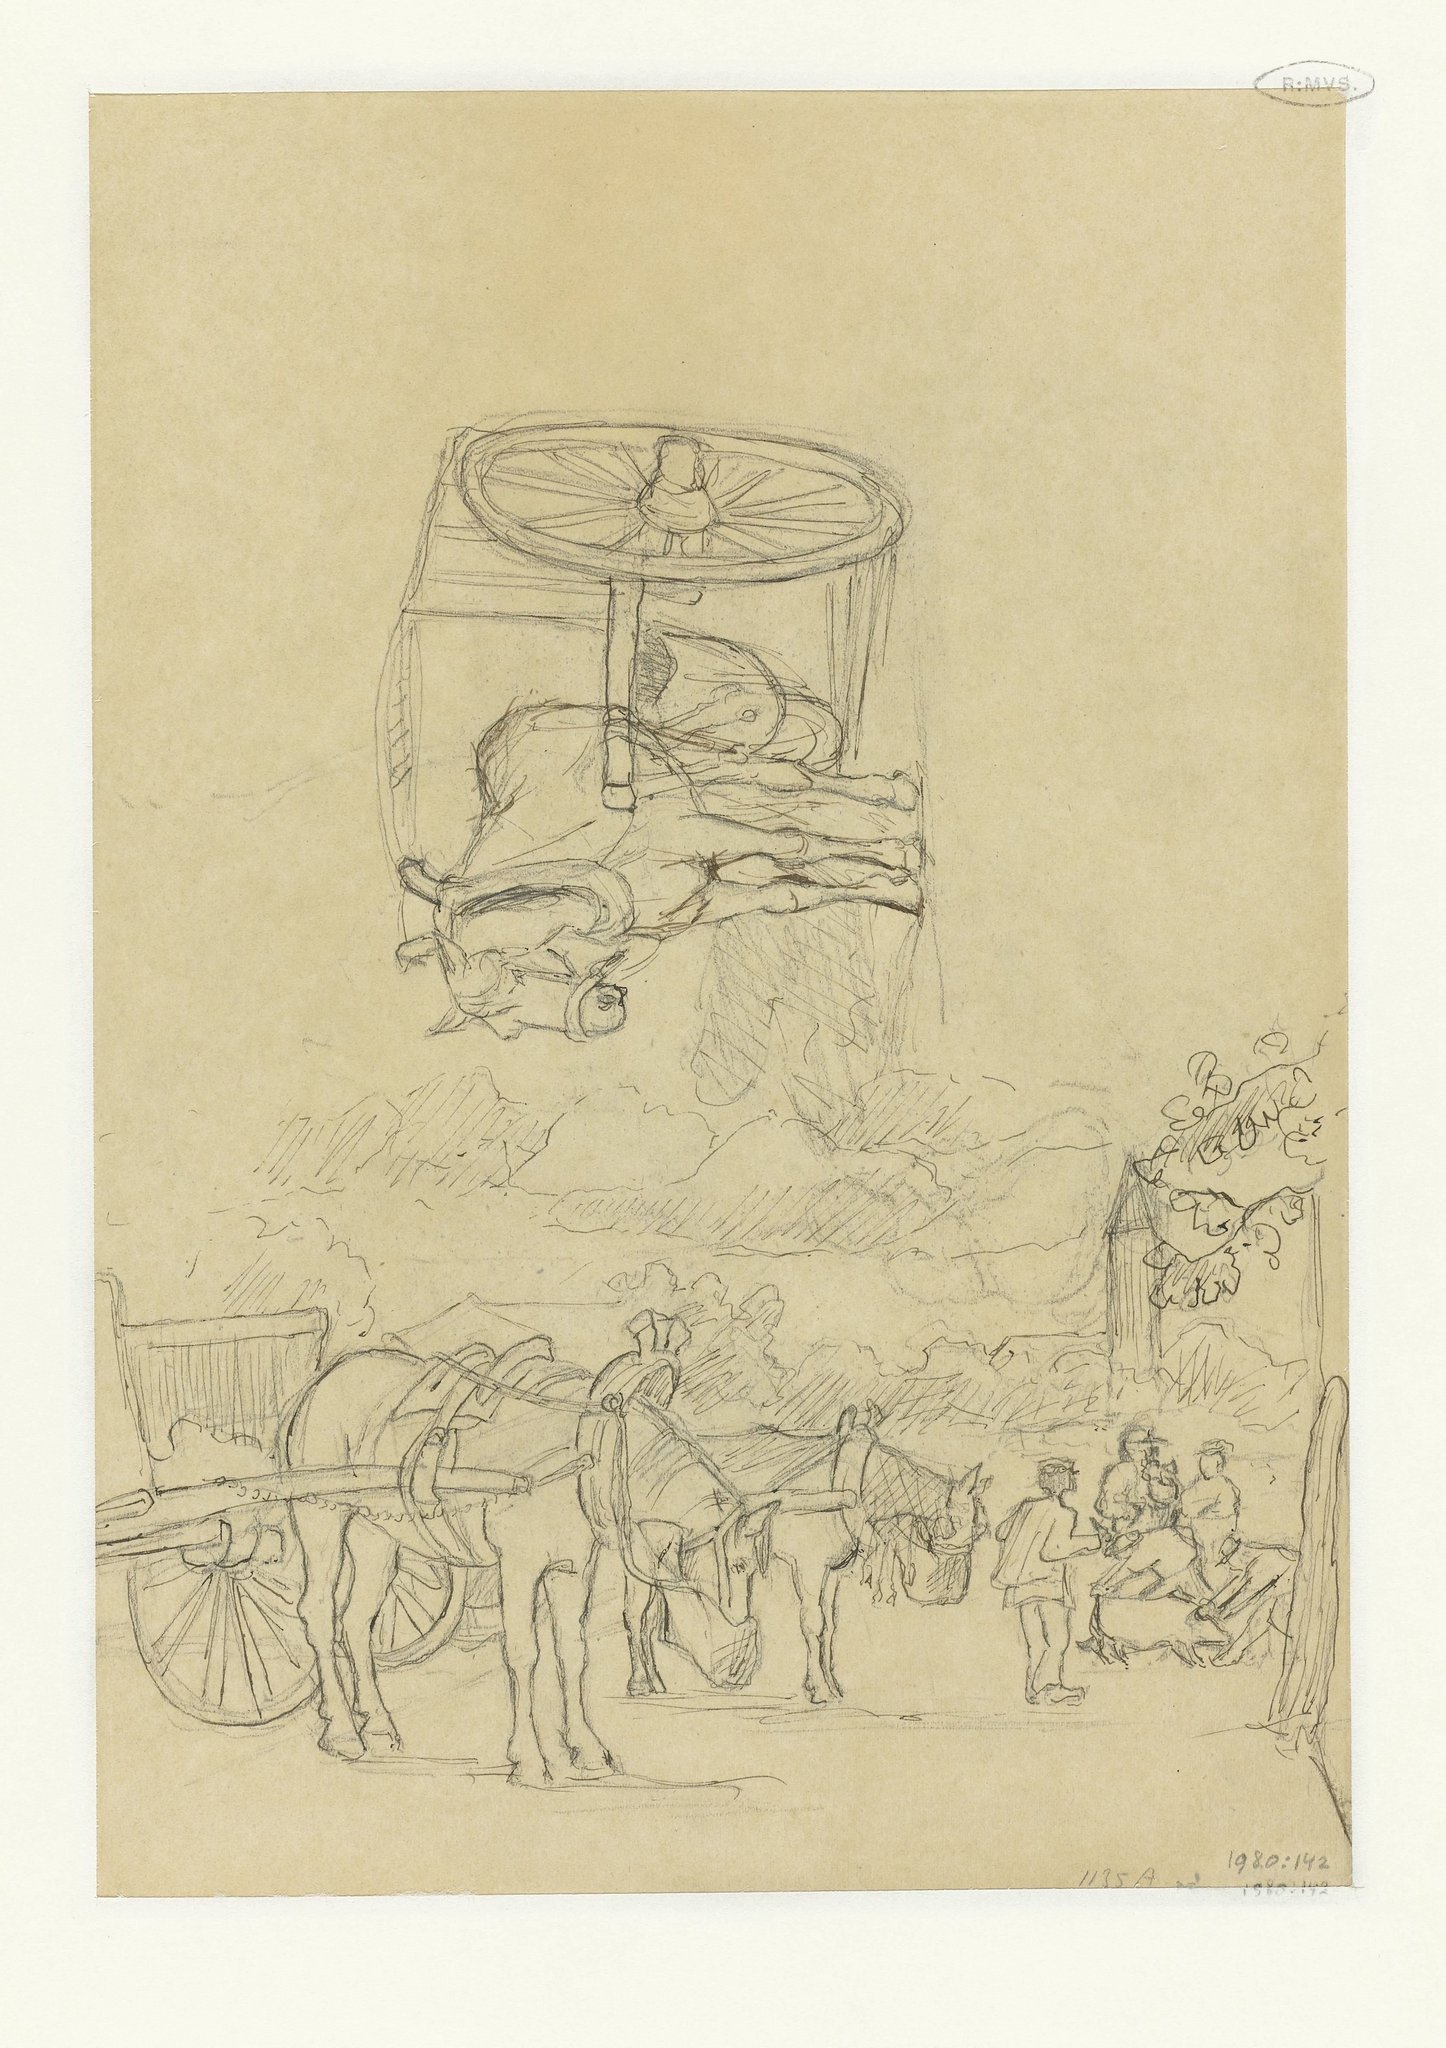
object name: drawing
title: Studieblad met ingespannen paarden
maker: jozef israëls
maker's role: draughtsman, painter, print maker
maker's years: 1824-1911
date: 1834-1911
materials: ink, paper, pencil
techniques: pen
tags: (farm) wagon, freight wagon, cart